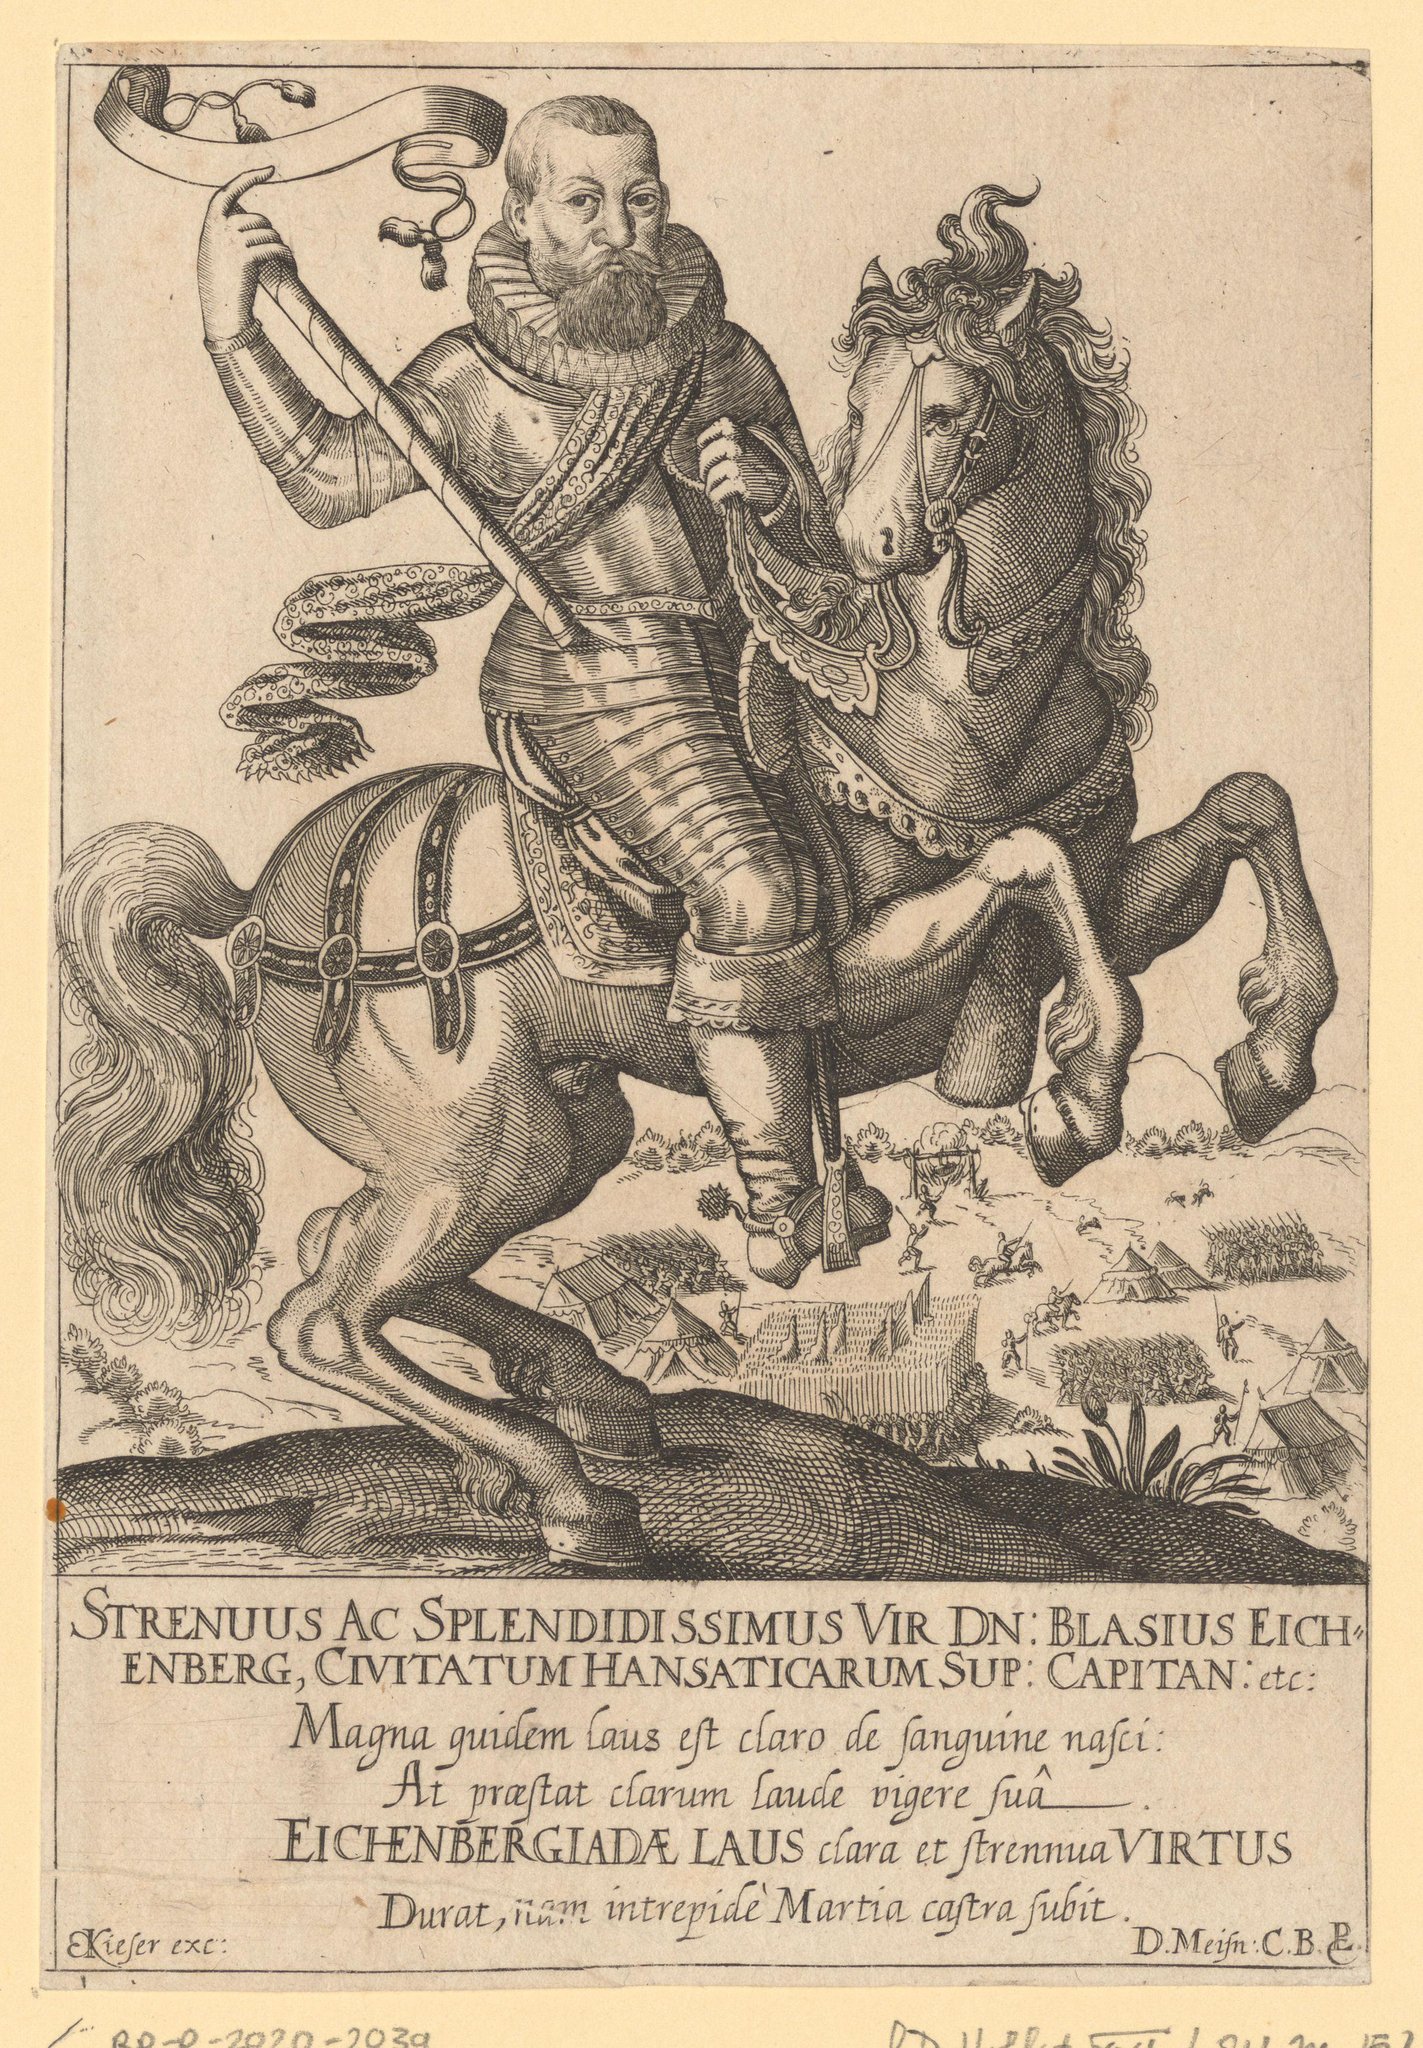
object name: print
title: Portret van Blasius von Eichenberg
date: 1609-1631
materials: paper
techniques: engraving, etching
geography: frankfurt am main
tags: riding a horse, ass, or mule; rider, horseman, commander-in-chief, general, marshal, historical persons, battle (+ land forces)